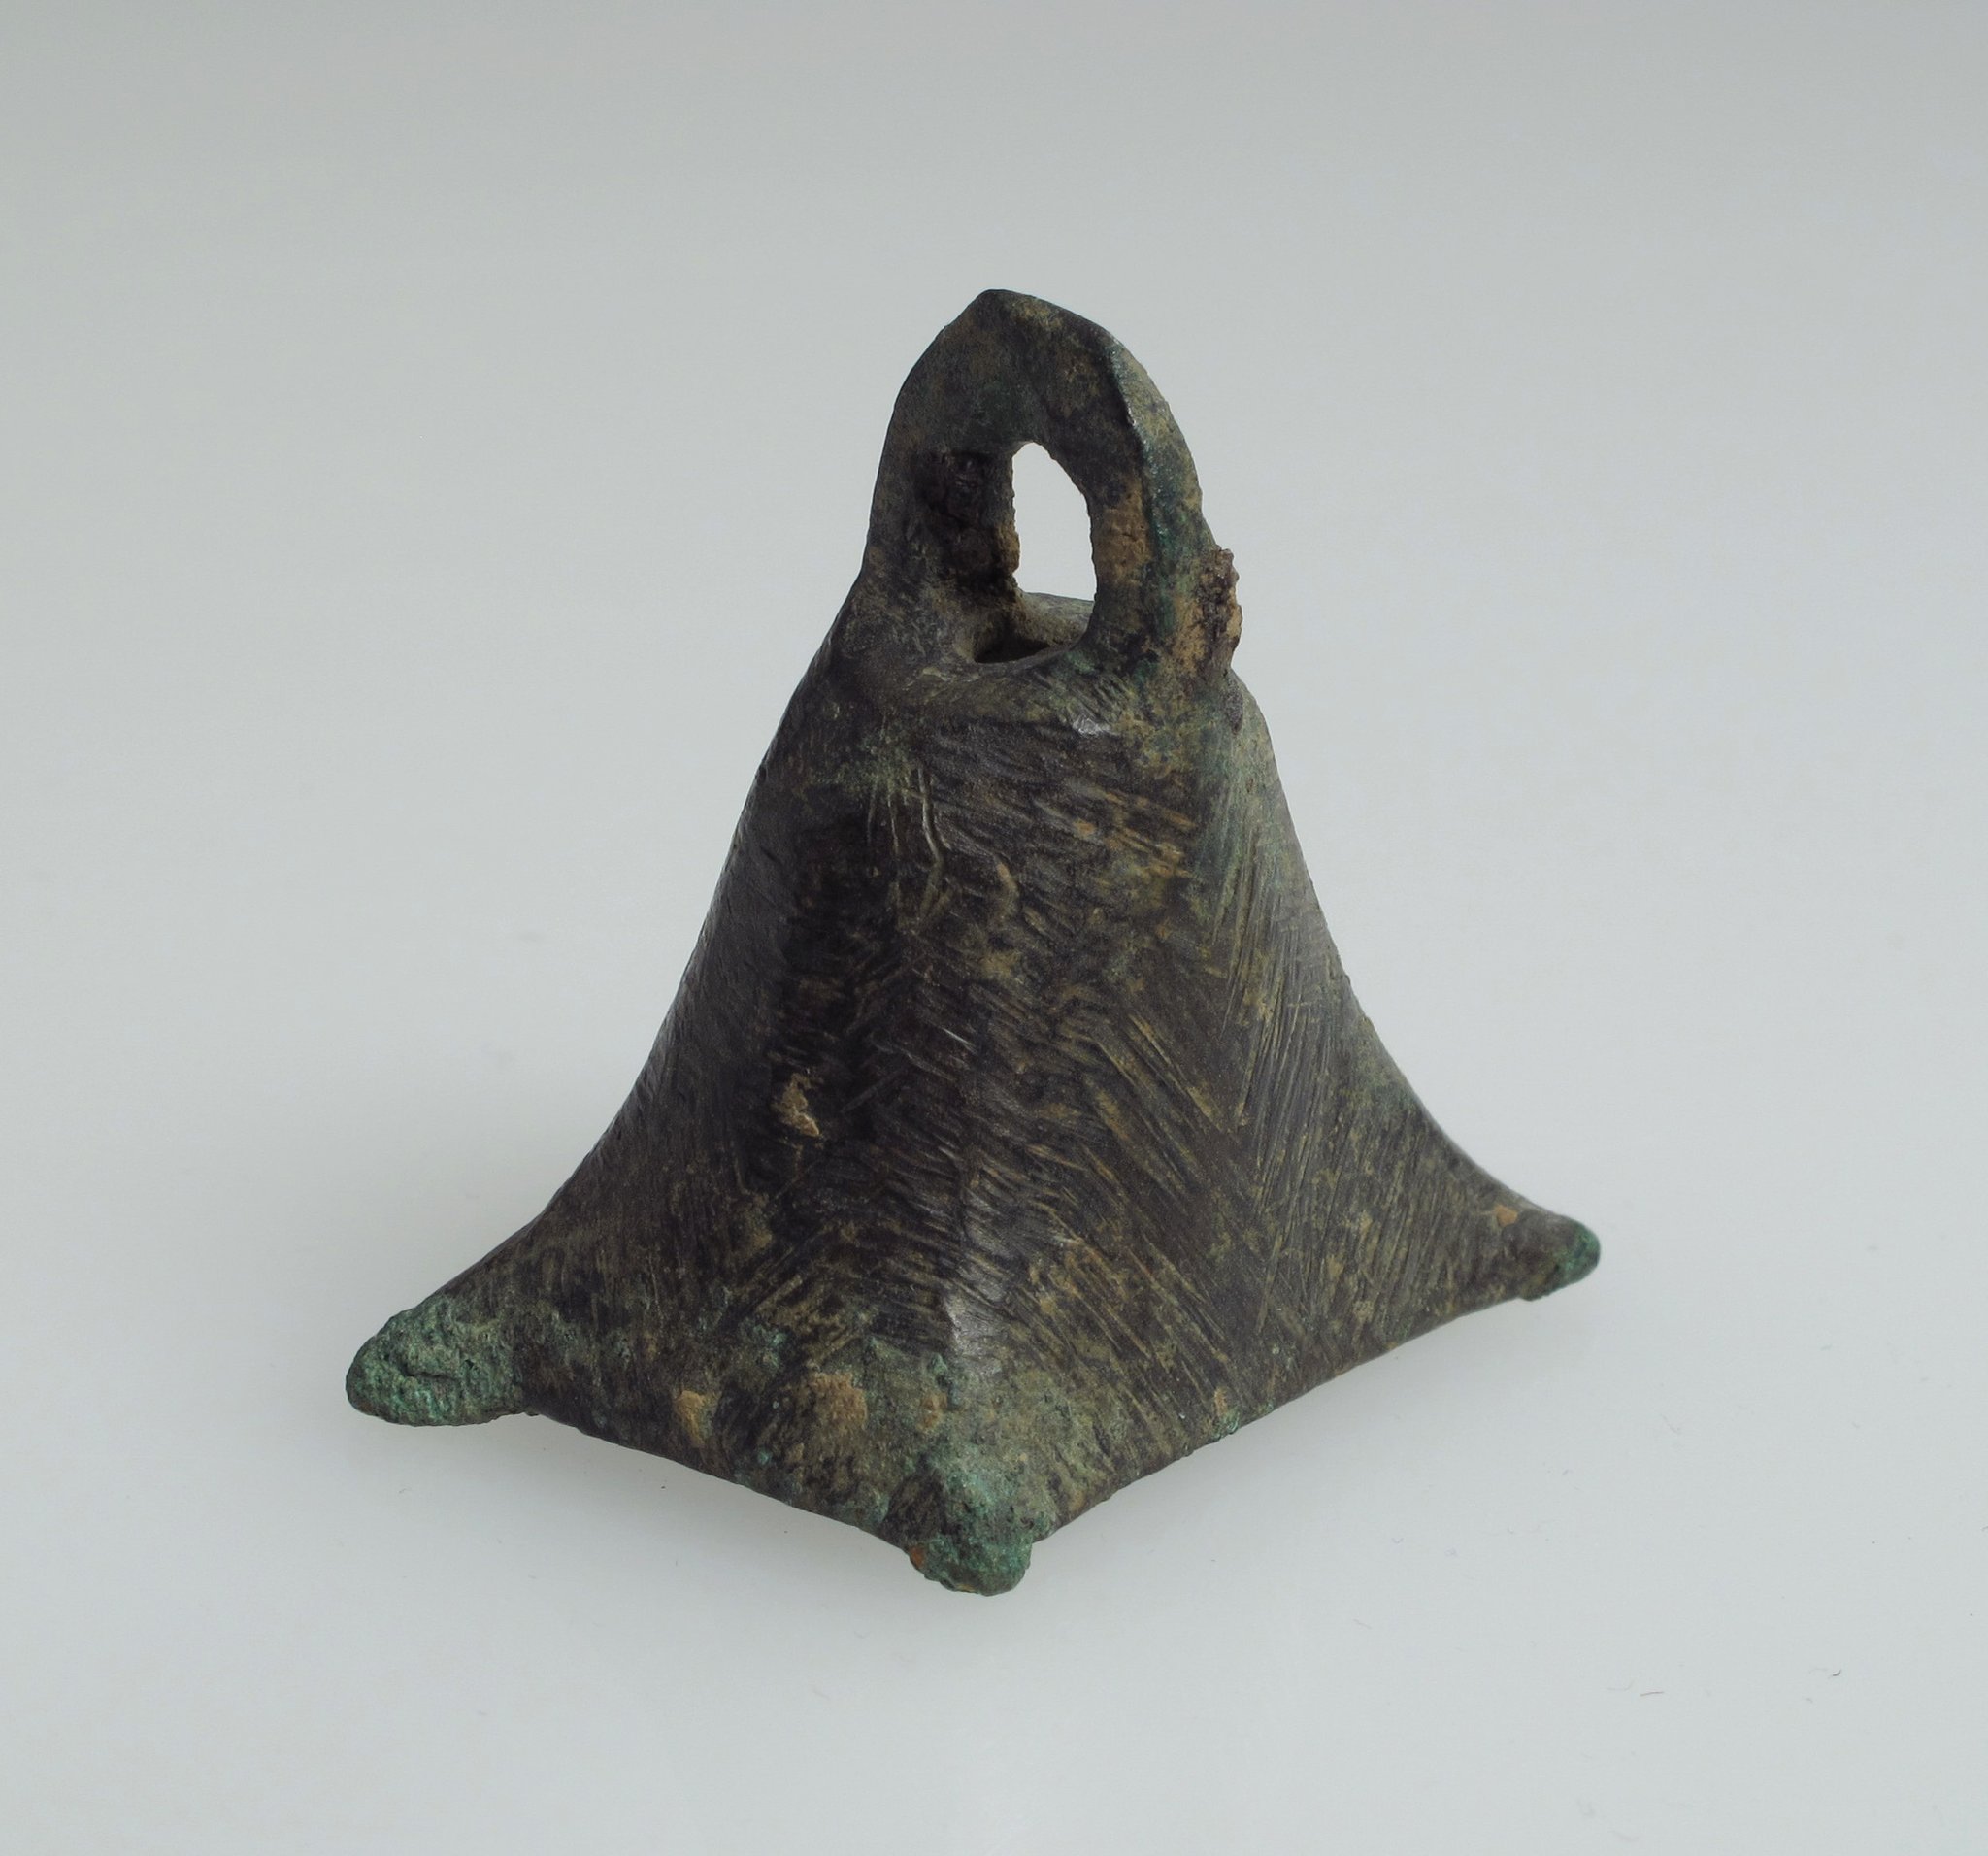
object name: bell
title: Square Pyramidal Bell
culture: frankish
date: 501-700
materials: copper alloy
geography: germany